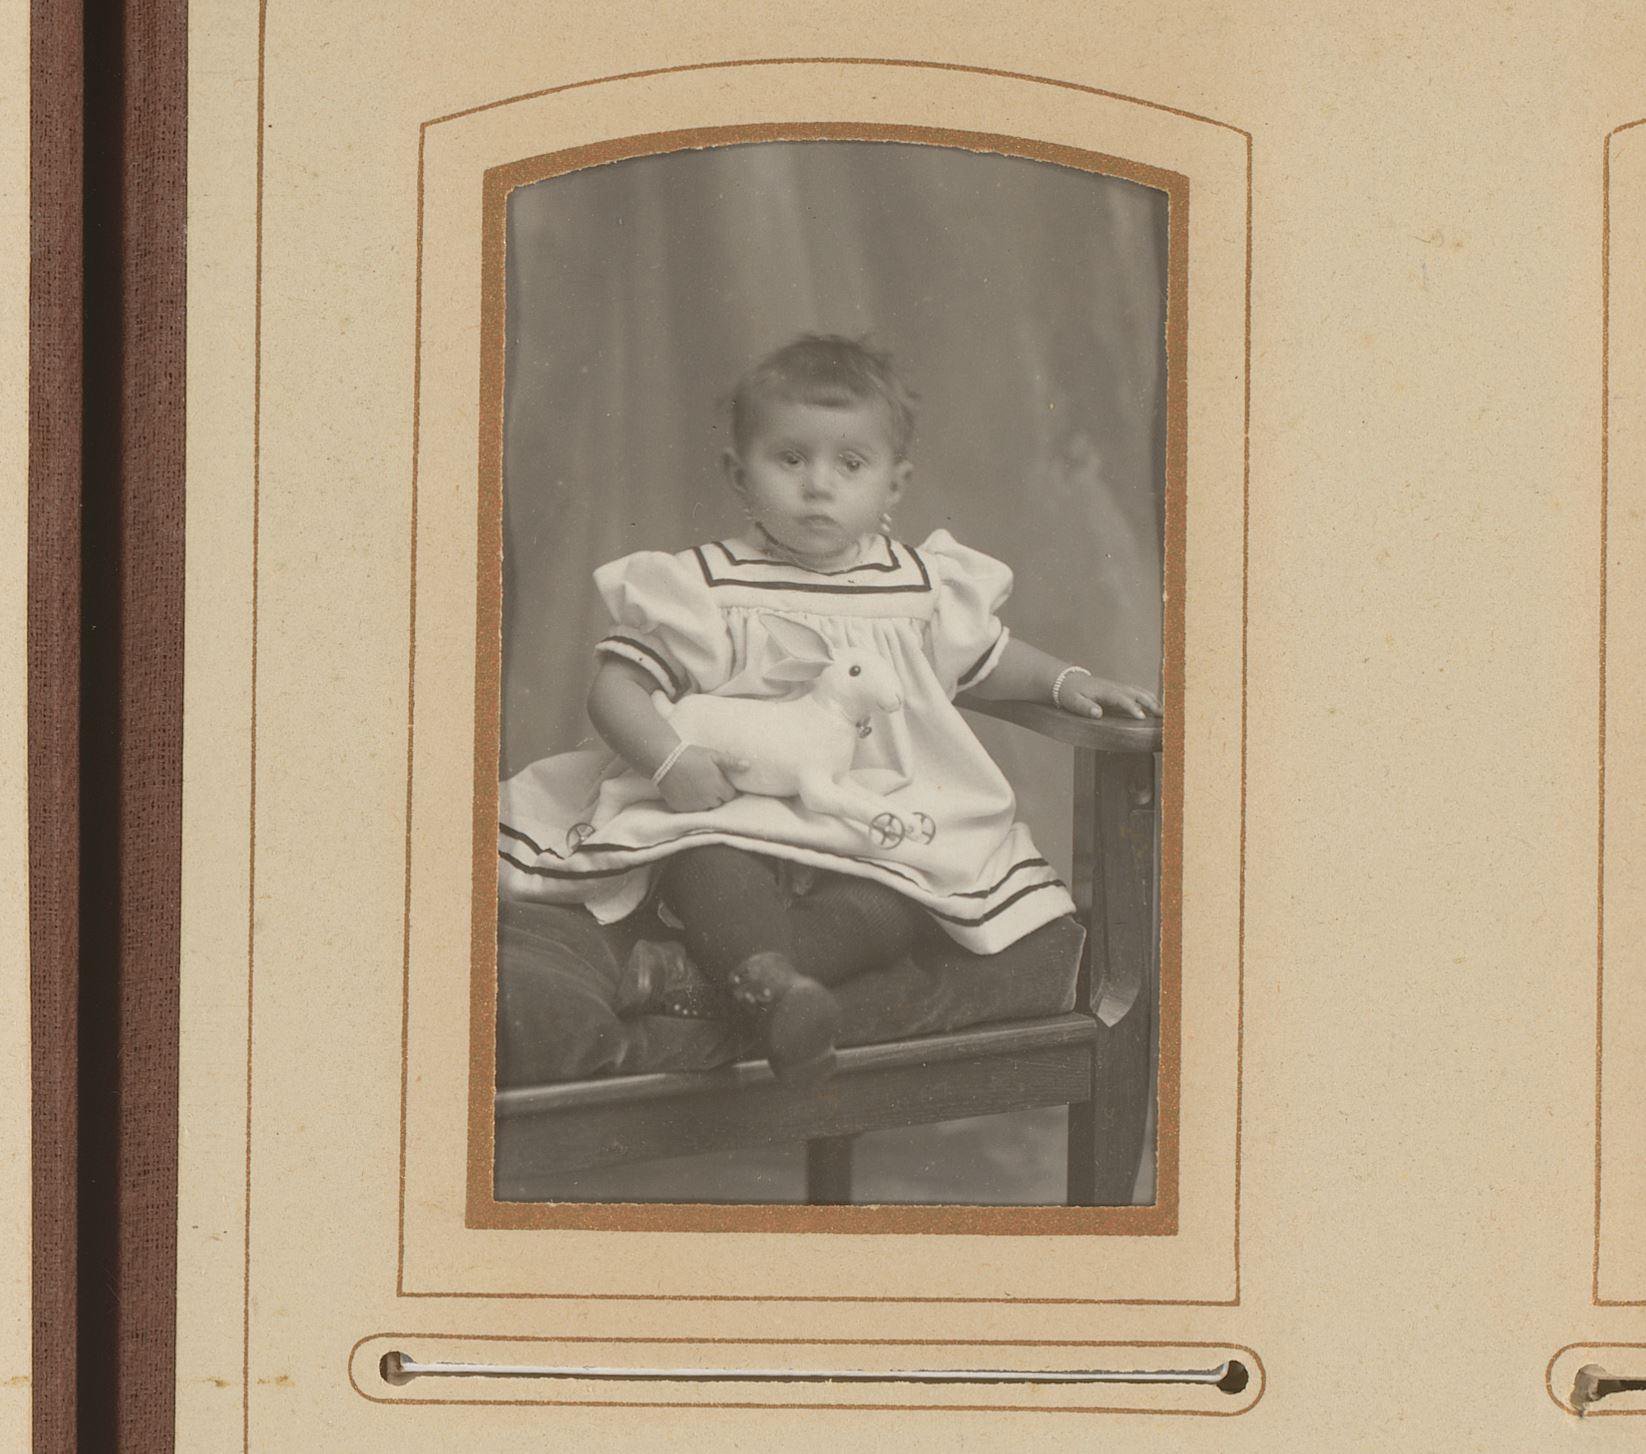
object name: carte de visite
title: Portret van een meisje met speelgoedkonijn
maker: berend zweers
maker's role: fotograaf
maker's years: 1872-1946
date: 1923-1934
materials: cardboard, photographic support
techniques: collodion silver print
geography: haarlem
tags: girl (child between toddler and youth)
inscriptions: inscription: ‘Berend Zweers/ Groote Houtstraat 174/ Haarlem’